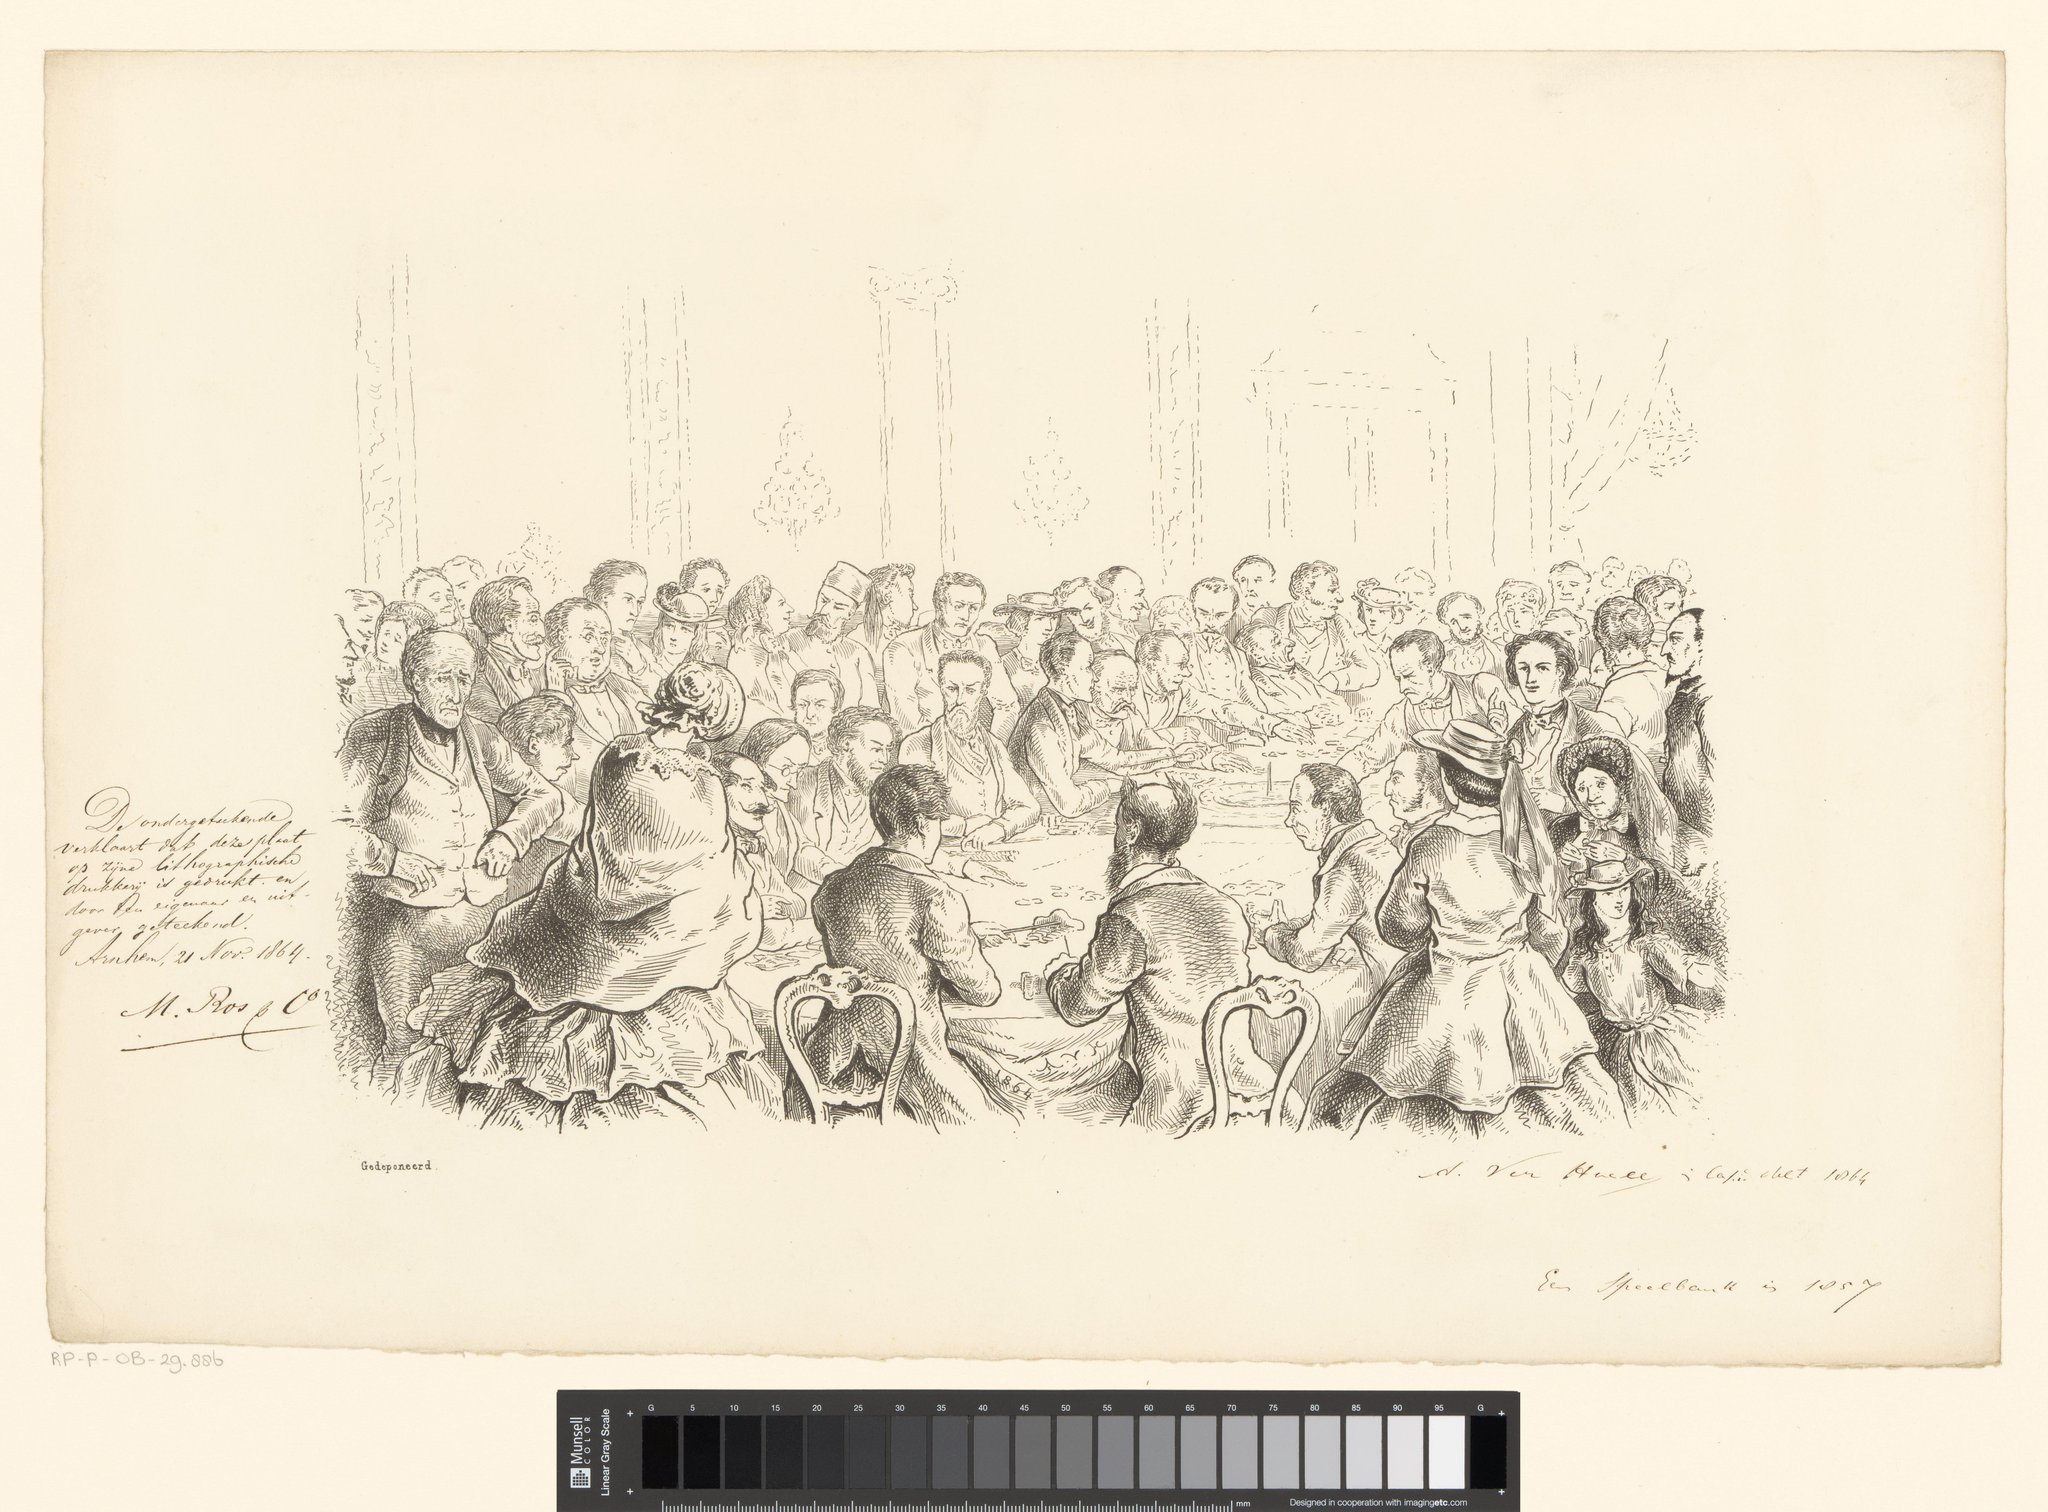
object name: print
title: Mensen rondom een speeltafel in een casino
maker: alexander ver huell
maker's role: draughtsman, print maker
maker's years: 1822-1897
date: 1864-1866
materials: paper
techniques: lithograph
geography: arnhem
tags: casino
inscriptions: : ‘Gedeponeerd.’, collector's mark: Lugt 2228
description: Een groep mannen zit rondom een speeltafel met in het midden een roulette. Omstanders kijken toe.